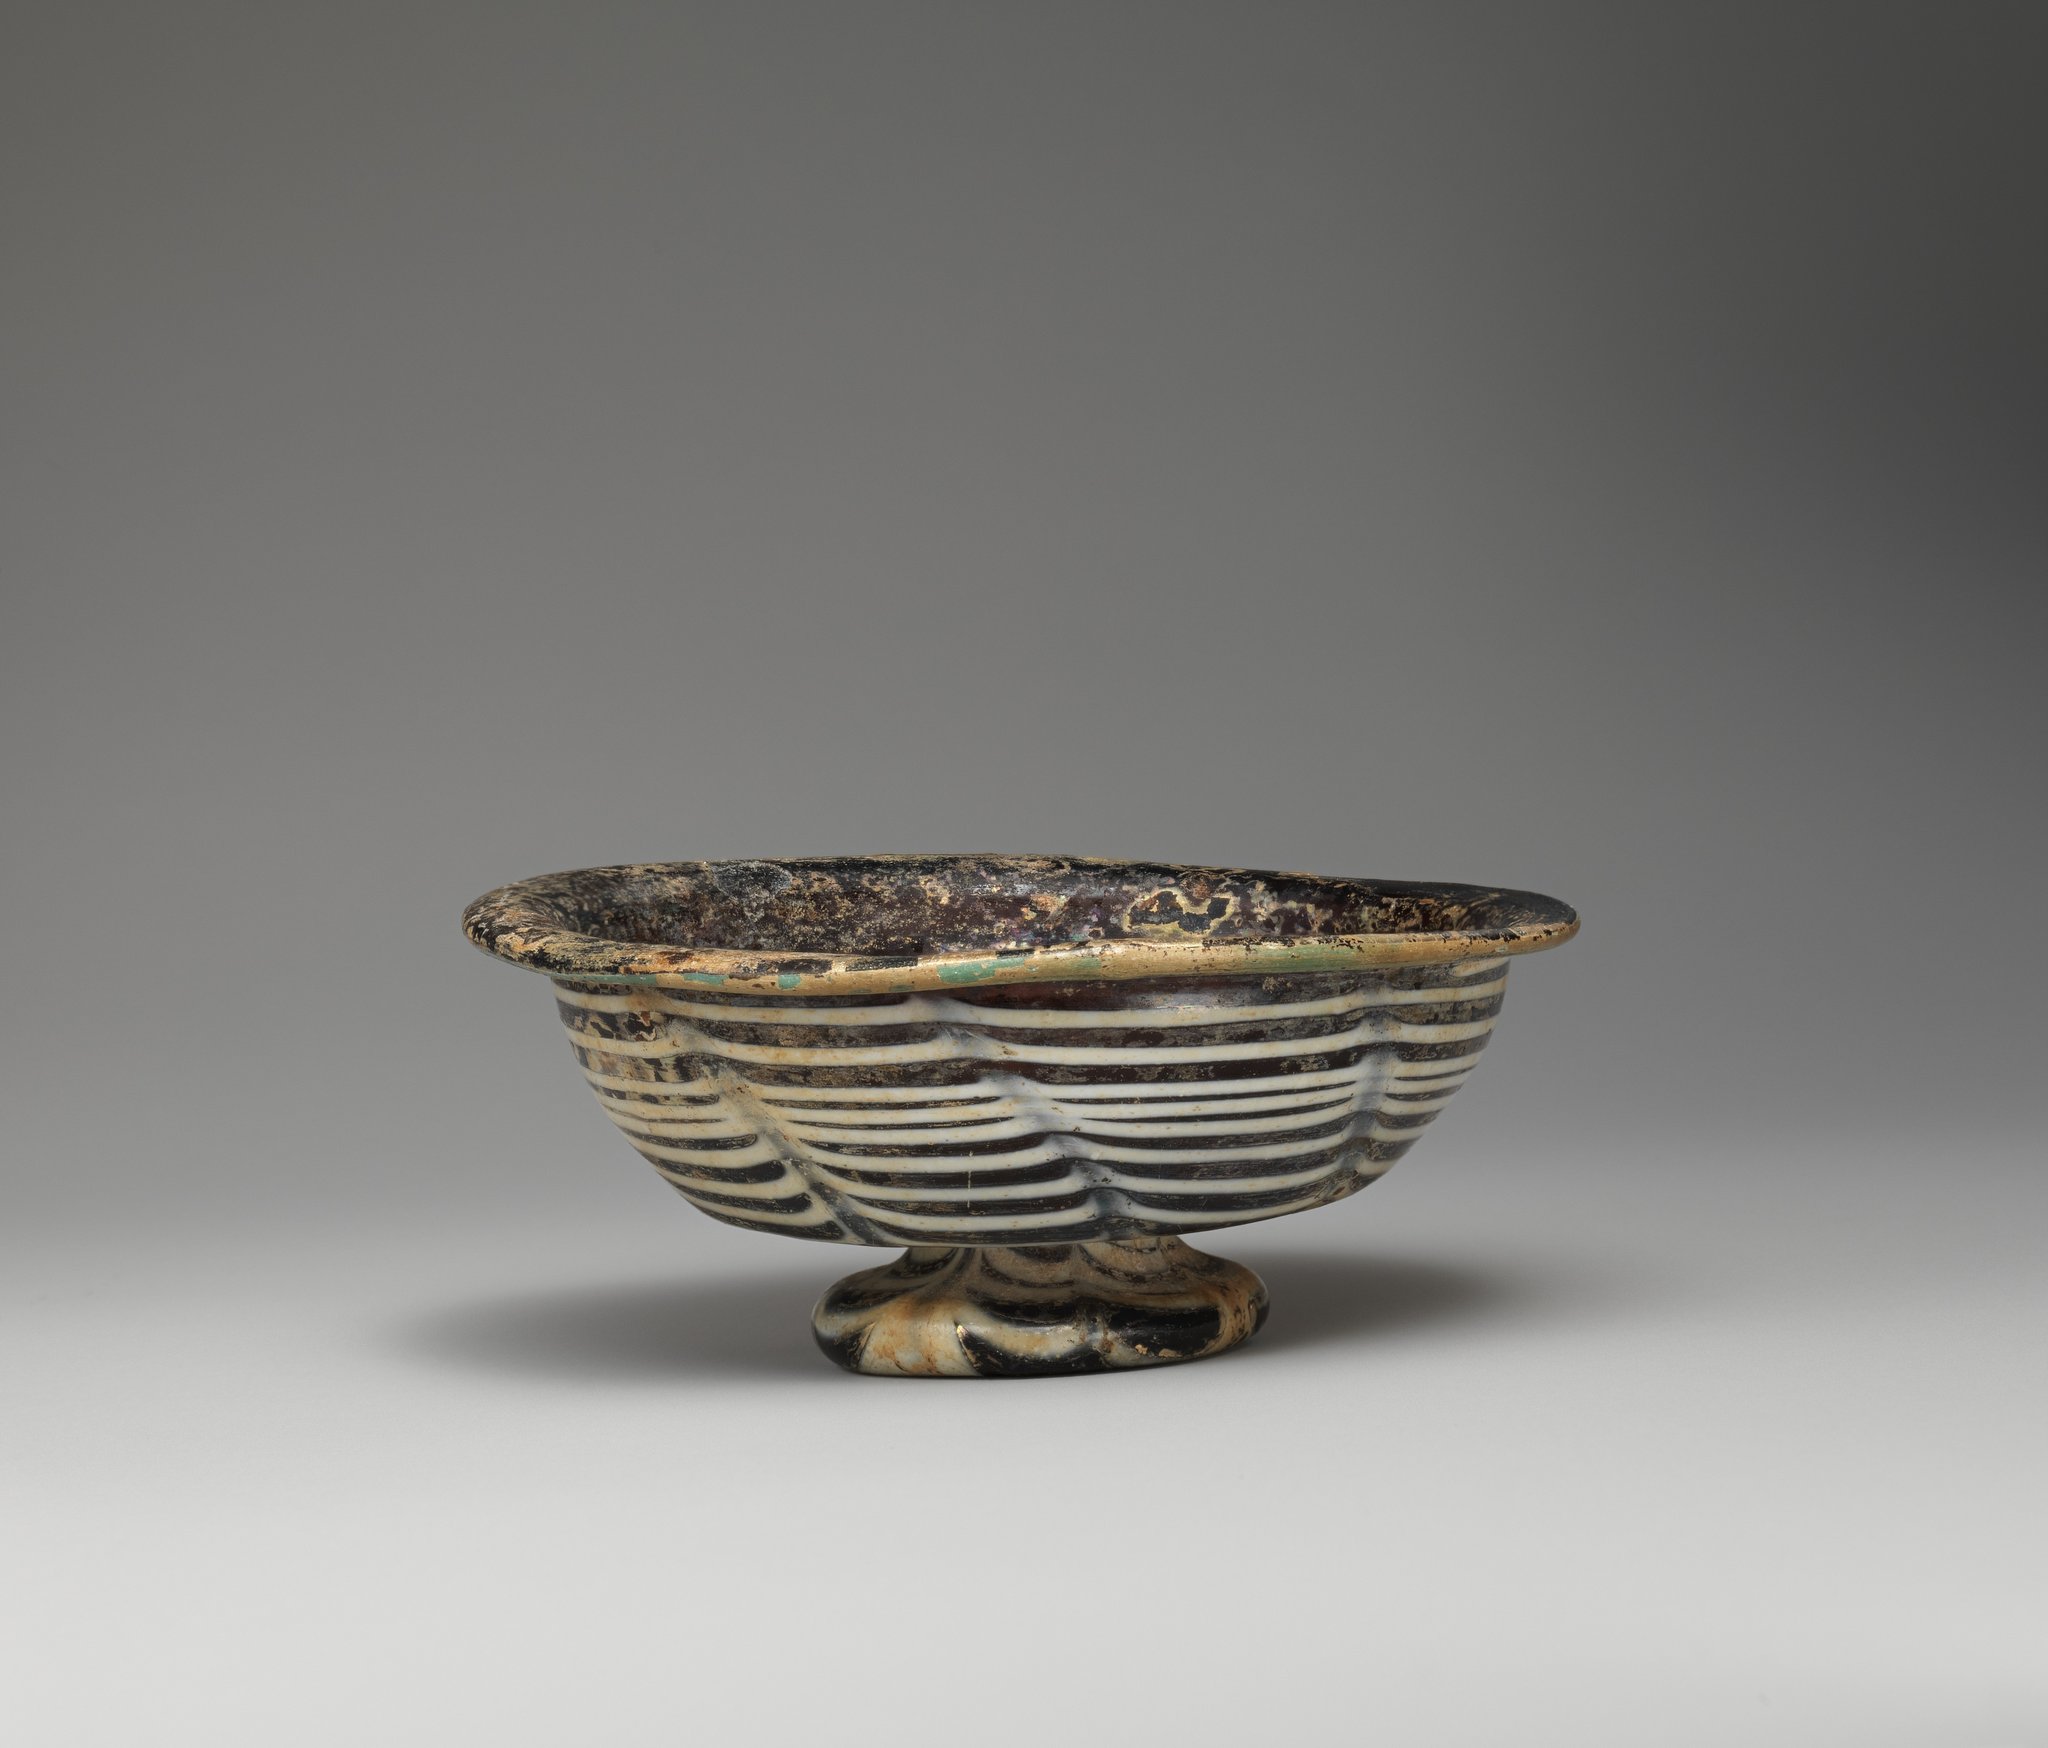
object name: bowl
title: Footed Bowl with Marvered Decoration in White and Turquoise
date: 1101-1400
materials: glass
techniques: glassblowing, tooling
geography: syria